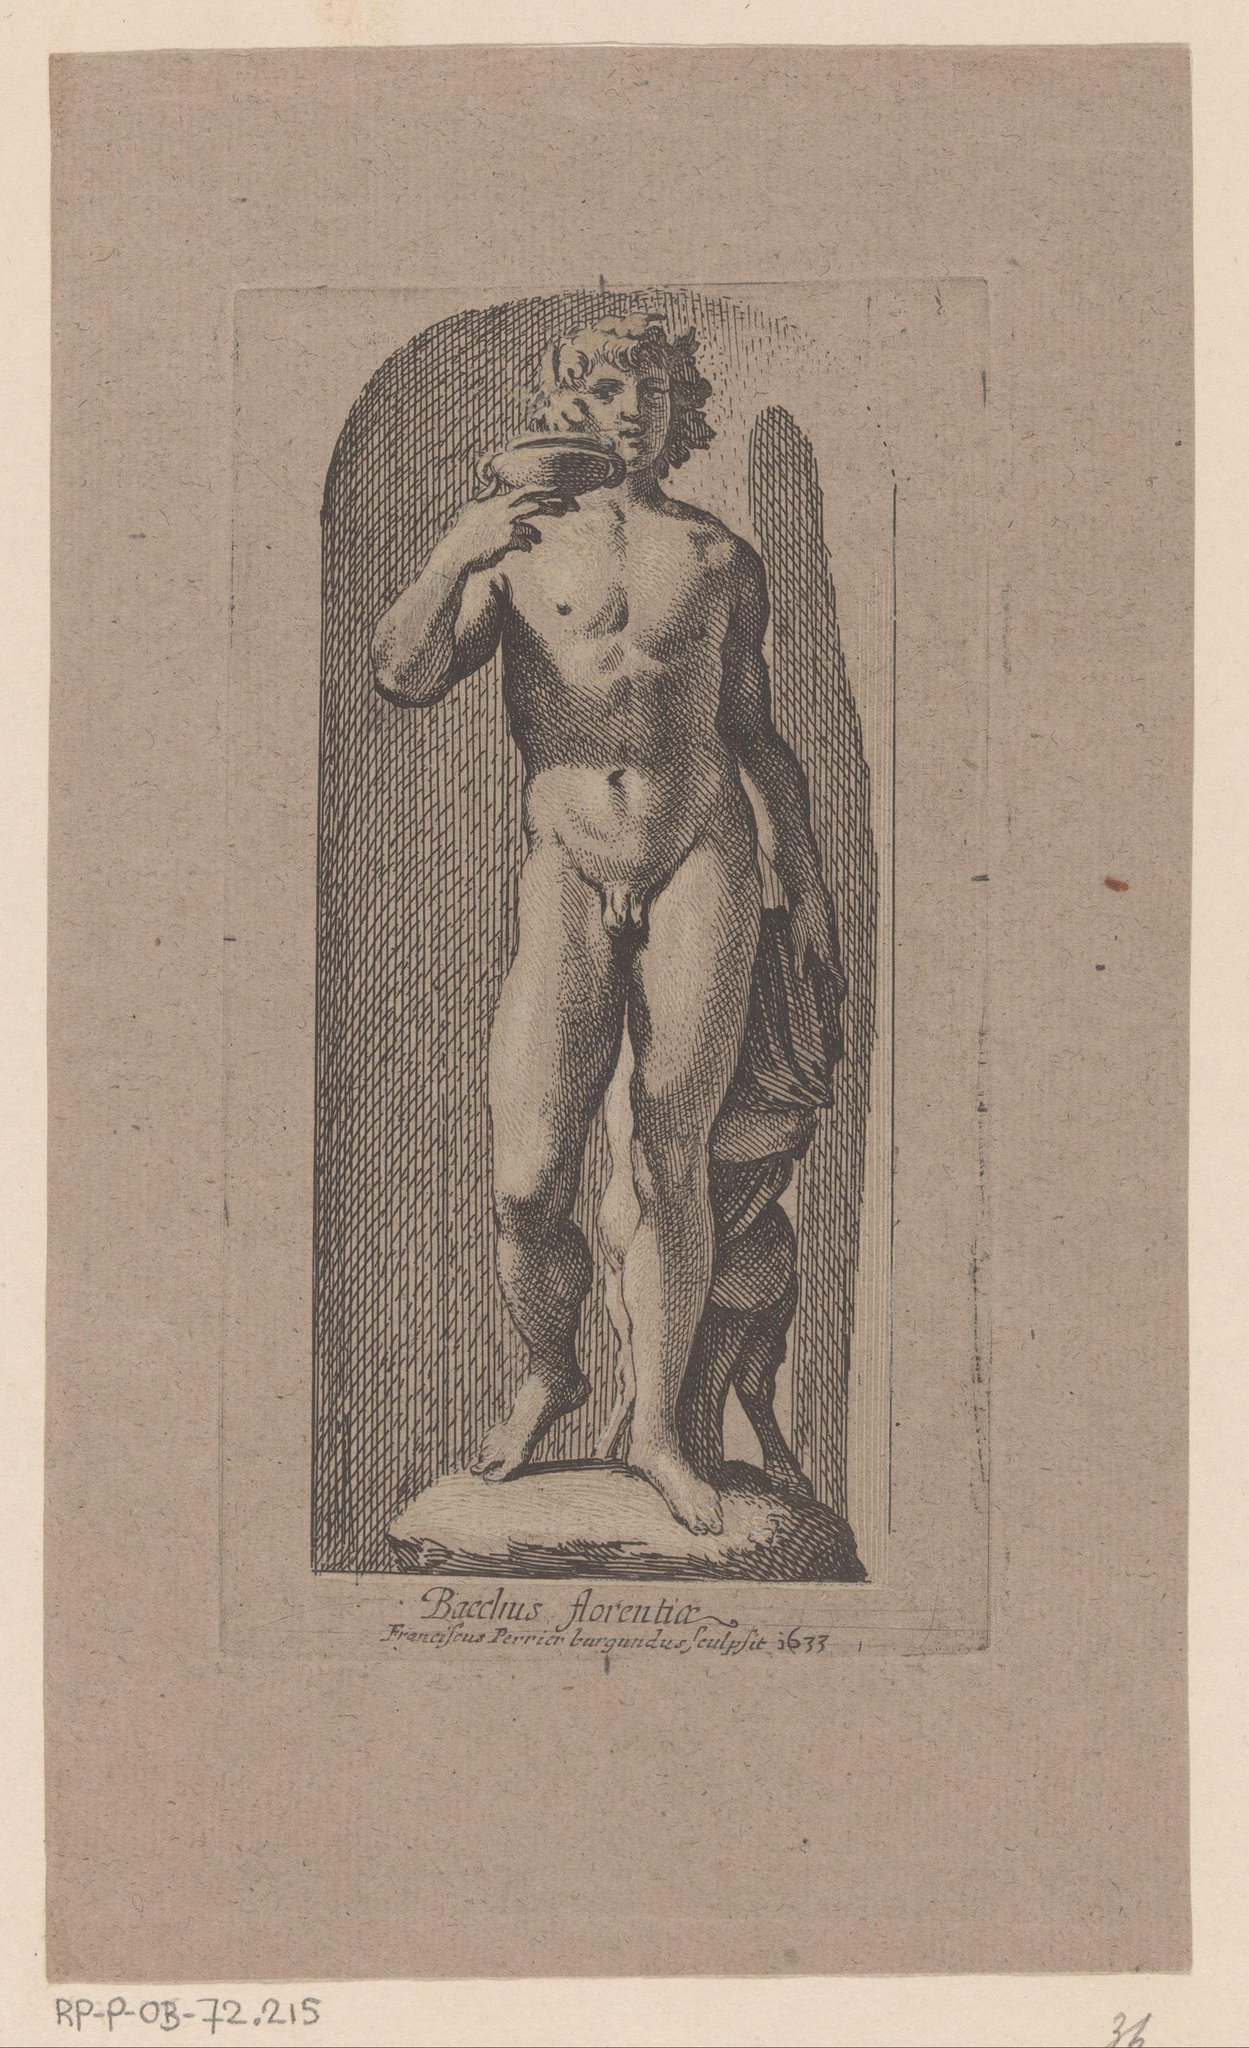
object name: print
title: Standbeeld van Bacchus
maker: françois perrier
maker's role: draughtsman, painter, print maker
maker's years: 1594-1649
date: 1633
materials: paper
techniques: etching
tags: piece of sculpture, reproduction of a piece of sculpture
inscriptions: collector's mark: Lugt 240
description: Prent maakt deel uit van een ongenummerde serie van zes prenten.